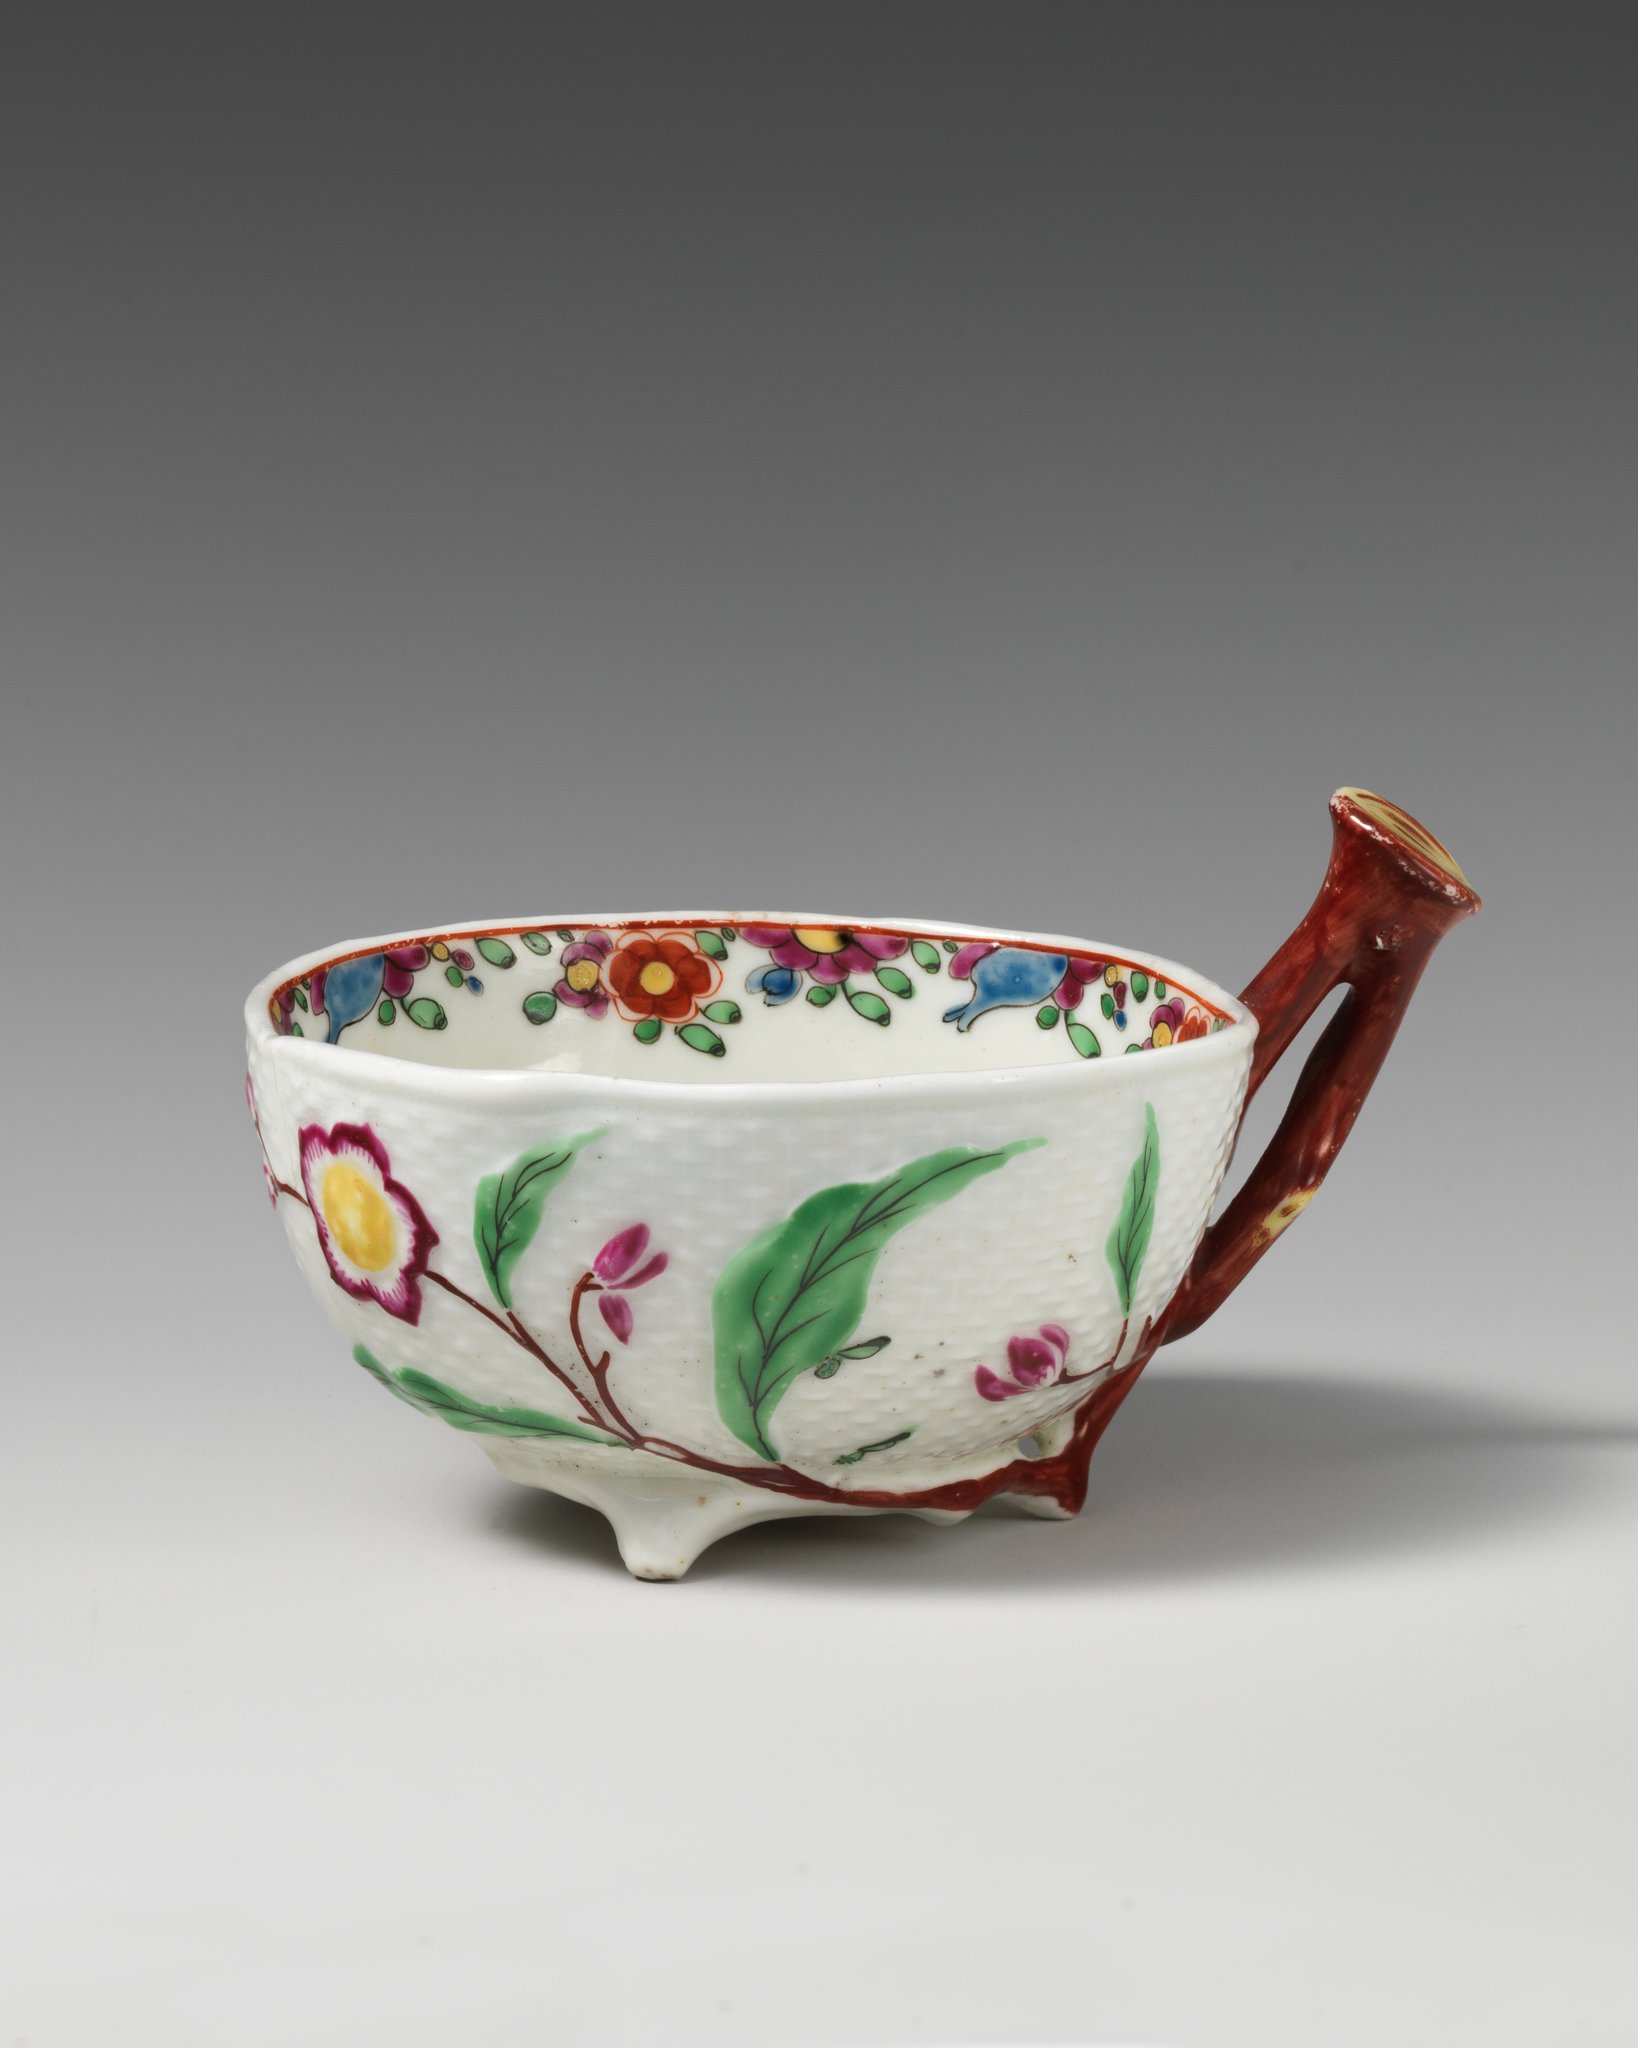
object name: cup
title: Cup (one of a pair)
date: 1765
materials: soft paste porcelain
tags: flowers